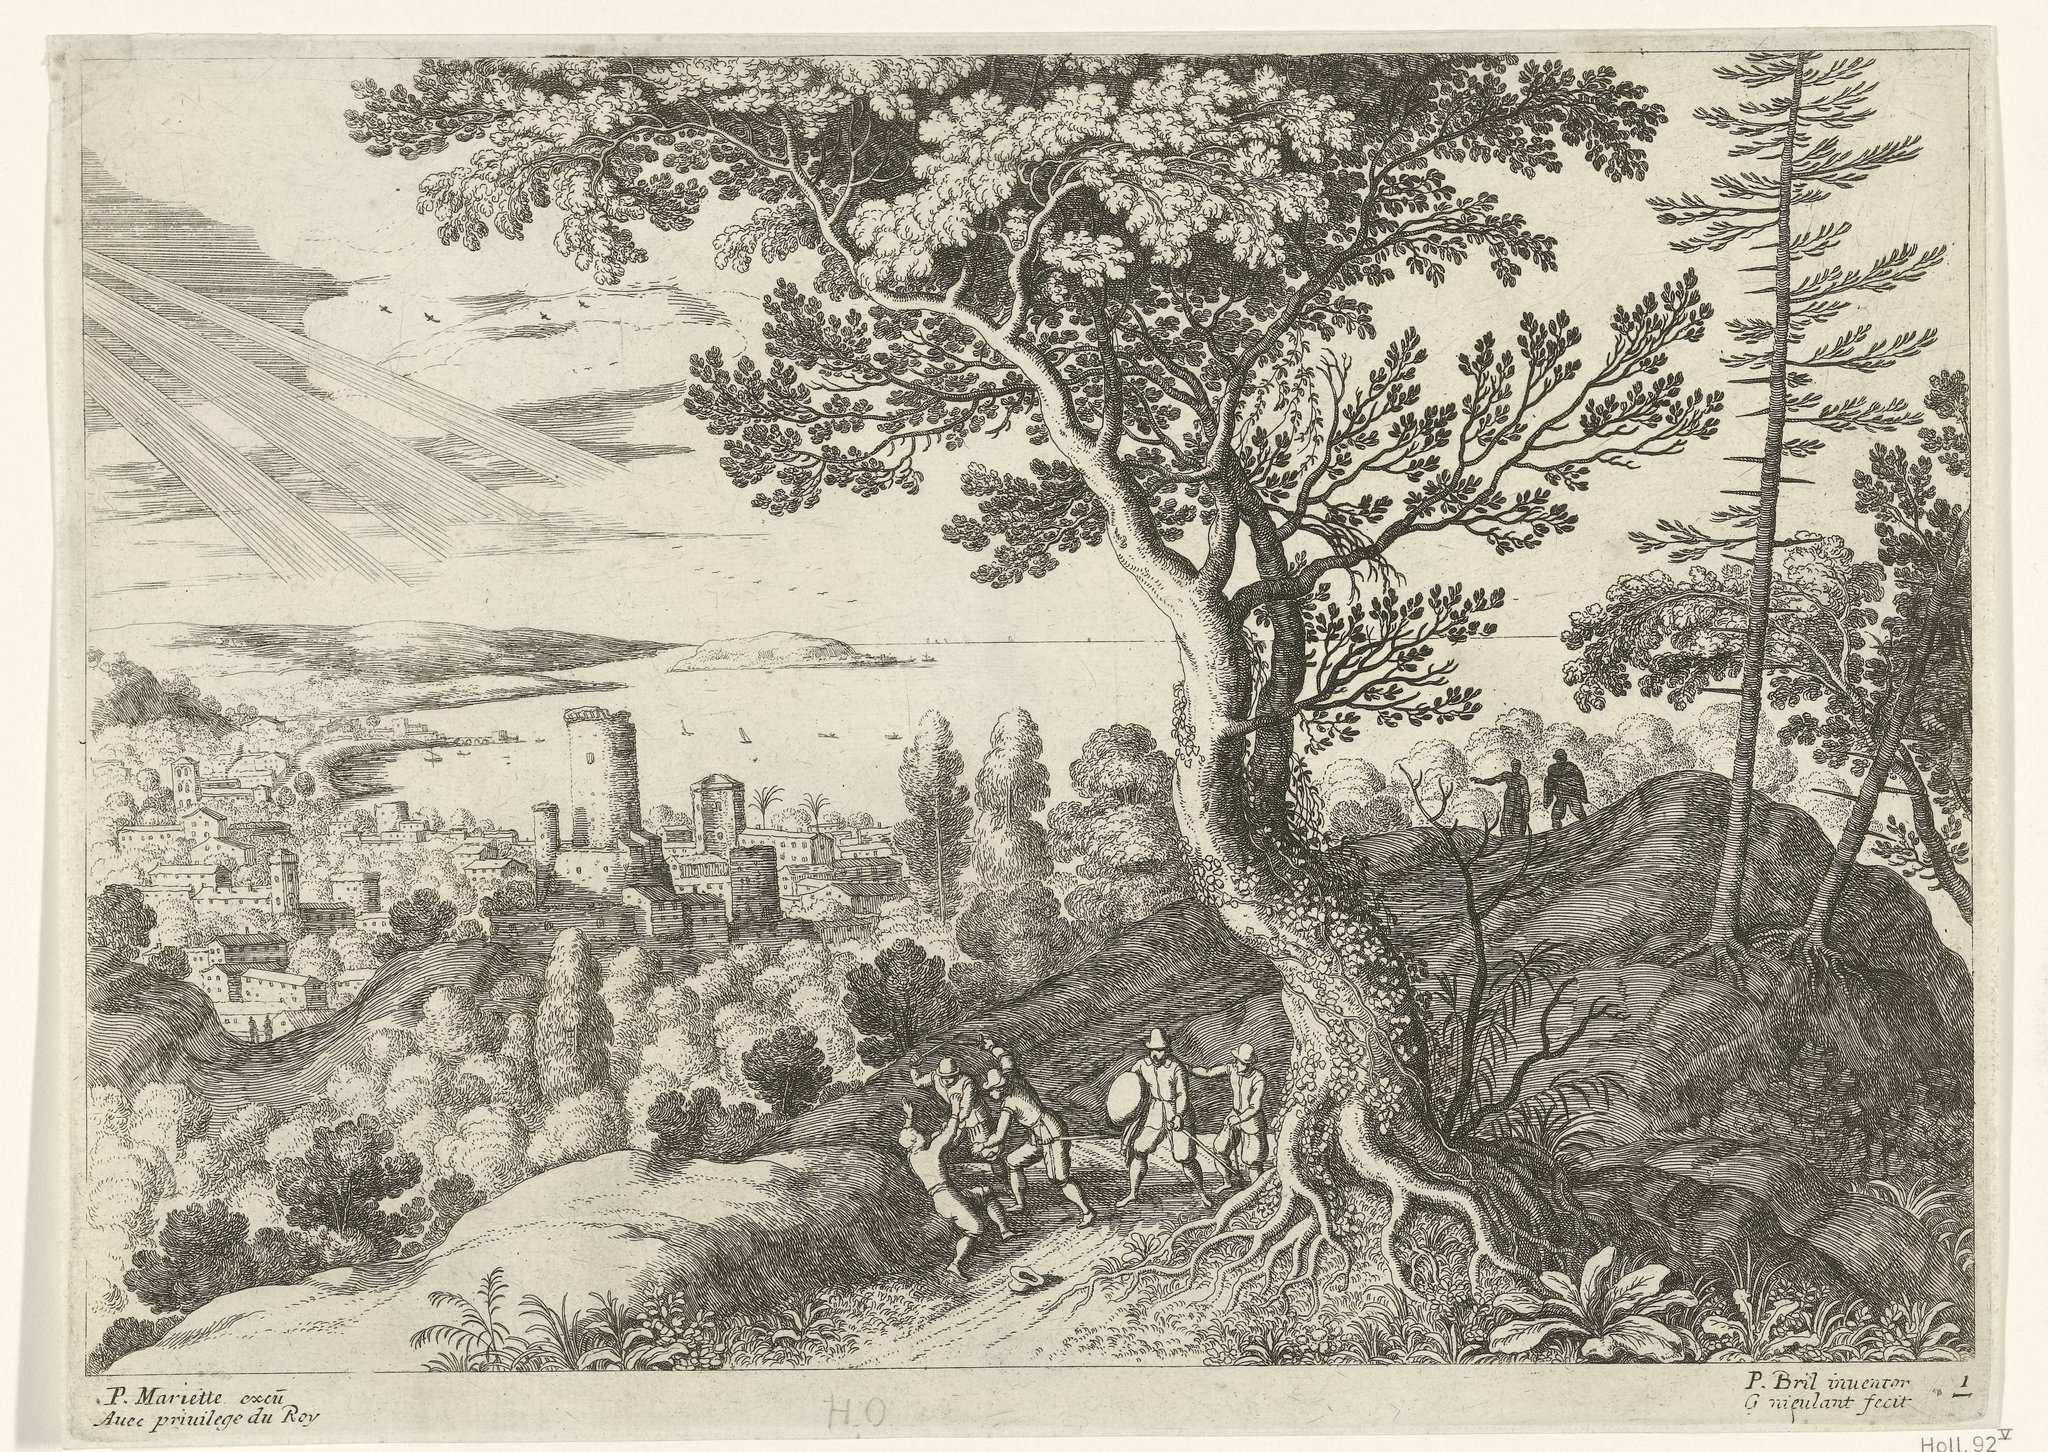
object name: print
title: Reiziger wordt aangevallen door rovers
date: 1594-1635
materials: paper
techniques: engraving, etching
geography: paris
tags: prospect of city, town panorama, silhouette of city - ii - ideal city, low hill country - hh - ideal landscapes, the traveller is attacked by robbers ~ parable of the good samaritan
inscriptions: collector's mark: Lugt 2228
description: In een landschap wordt een man aangevallen en mishandeld door vier rovers. Op de heuvel kijken twee mannen toe. Waarschijnlijk gaat het hier om de man die wordt overvallen uit het Bijbelverhaal van de barmhartige Samaritaan in Luc. 10: 25-37. Links uitzicht over een stad aan de zee. Prent uit een serie Italiaanse landschappen.